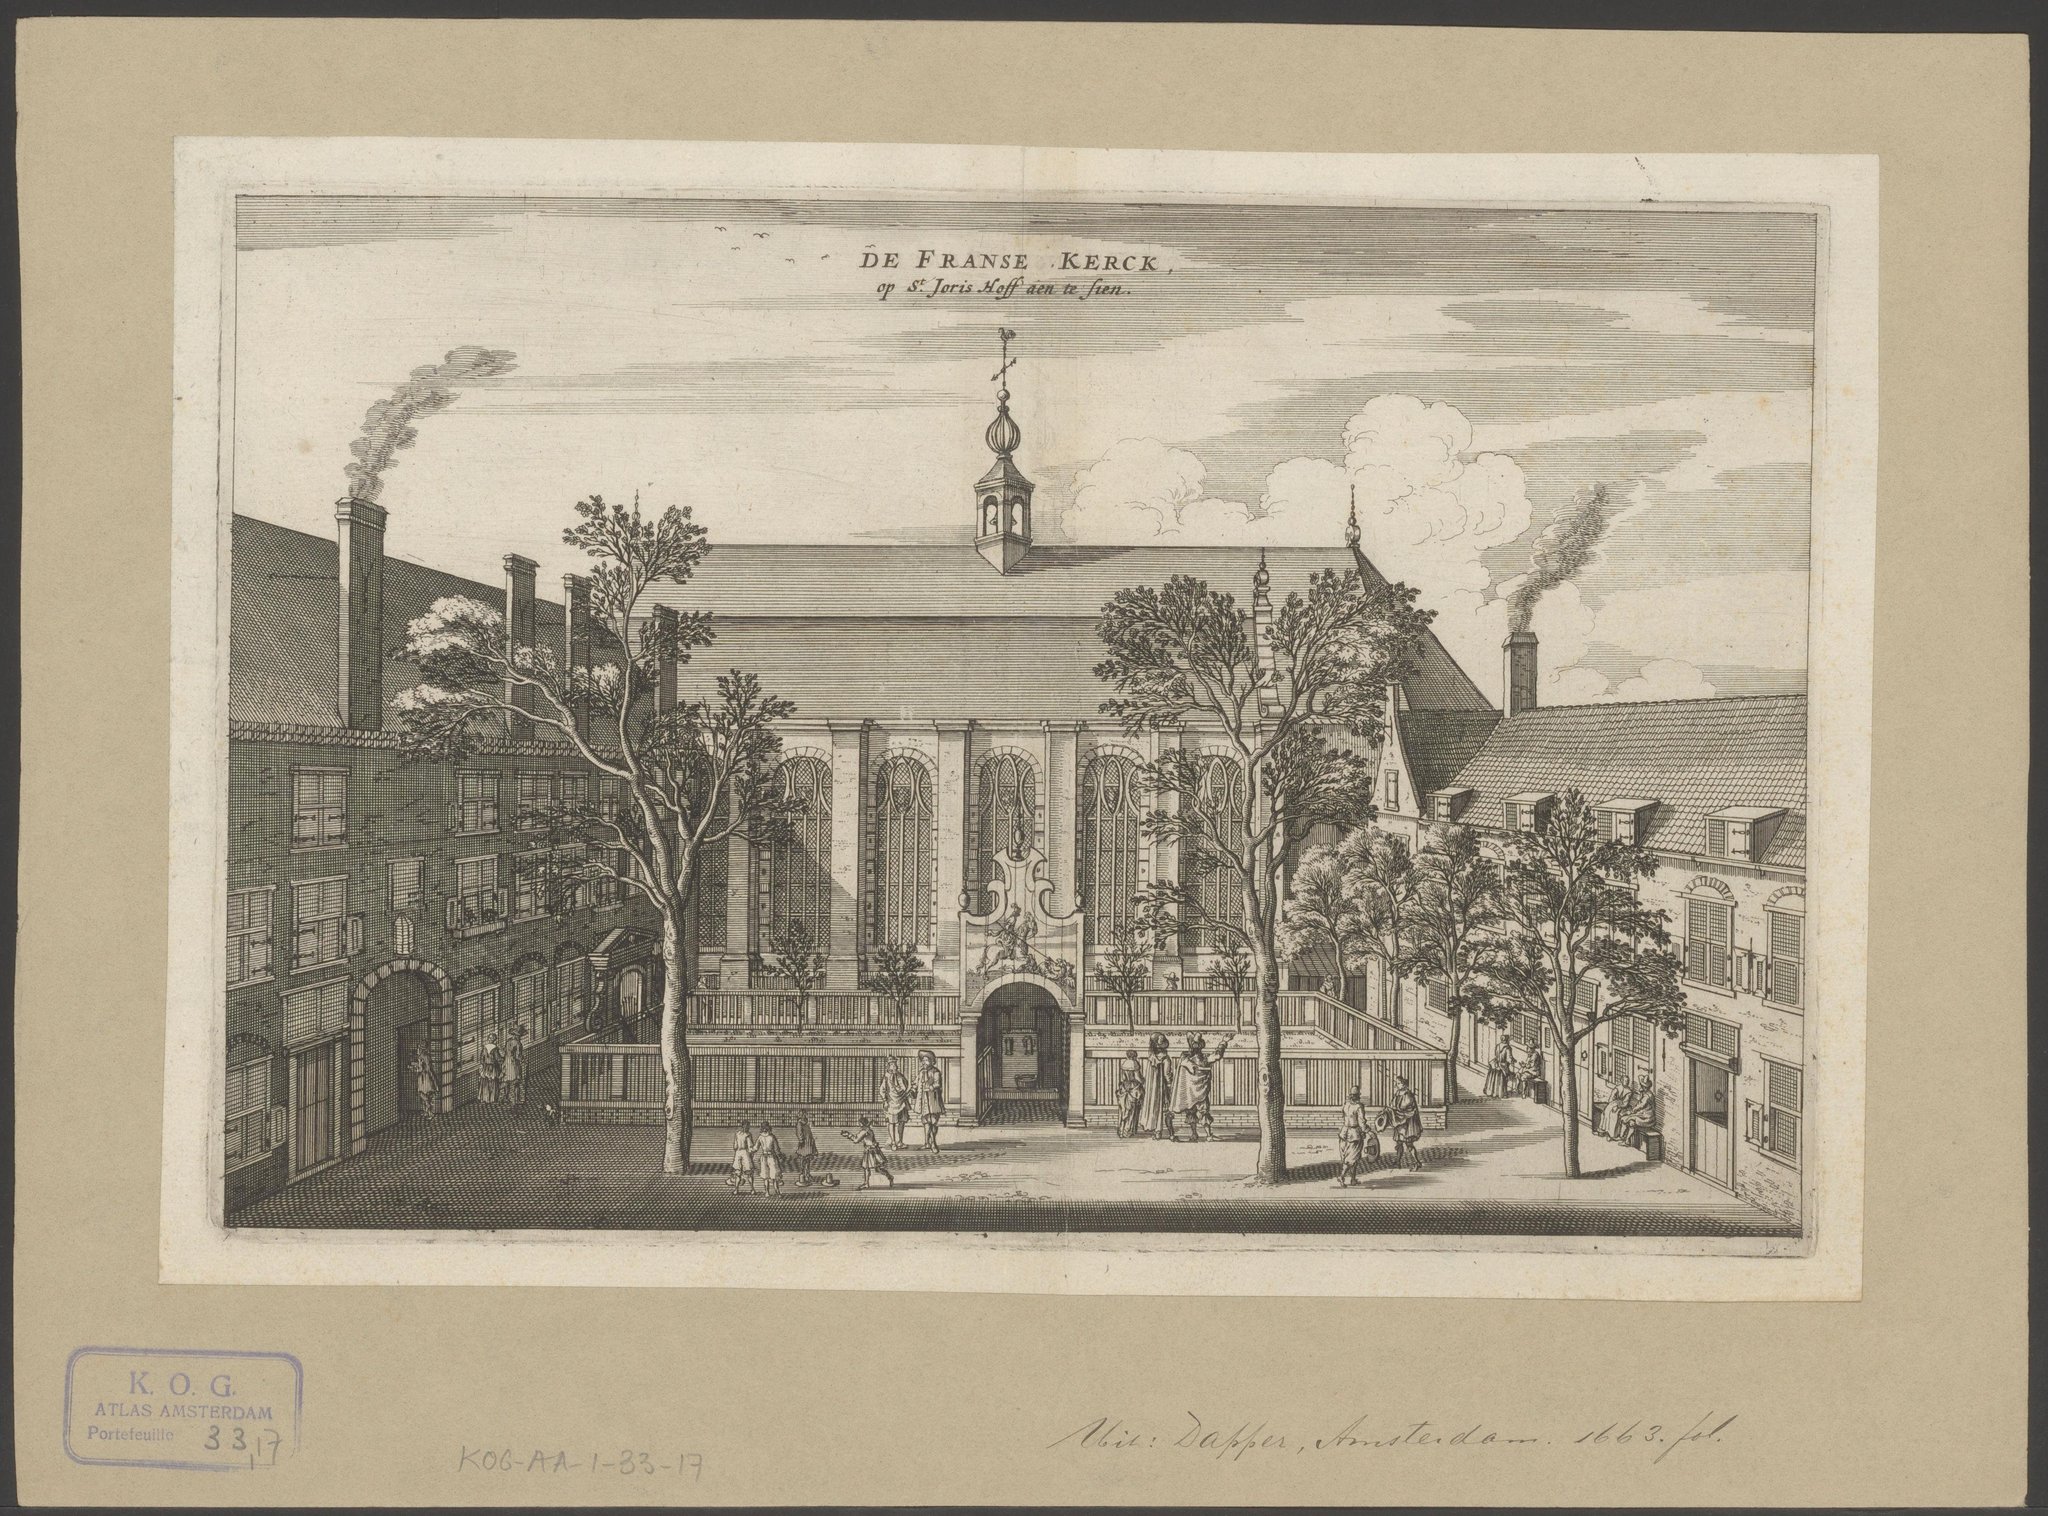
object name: print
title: De Franse Kerck, op St. Joris Hoff aen te sien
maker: jacob van meurs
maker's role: draughtsman, print maker, publisher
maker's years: 1619-1680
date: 1663-1664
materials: paper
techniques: engraving, etching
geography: amsterdam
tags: alms-house (dutch: 'hofje'), church (exterior), square, place, circus, etc. (+ city(-scape) with figures, staffage)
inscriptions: collector's mark: Lugt 1641b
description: Prent mogelijk uit: Dapper, Olfert. Historische beschryving der stadt Amsterdam (…). Amsterdam: Jacob van Meurs, 1663. Of uit: Zesen, Philipp von. Beschreibung der Stadt Amsterdam (…). Amsterdam: Joachim Nosche, 1664. Bij sommige exemplaren van eerstgenoemde uitgave werd een latere staat ingebonden waarop boven de Nederlandse titel ook een Franse is toegevoegd.